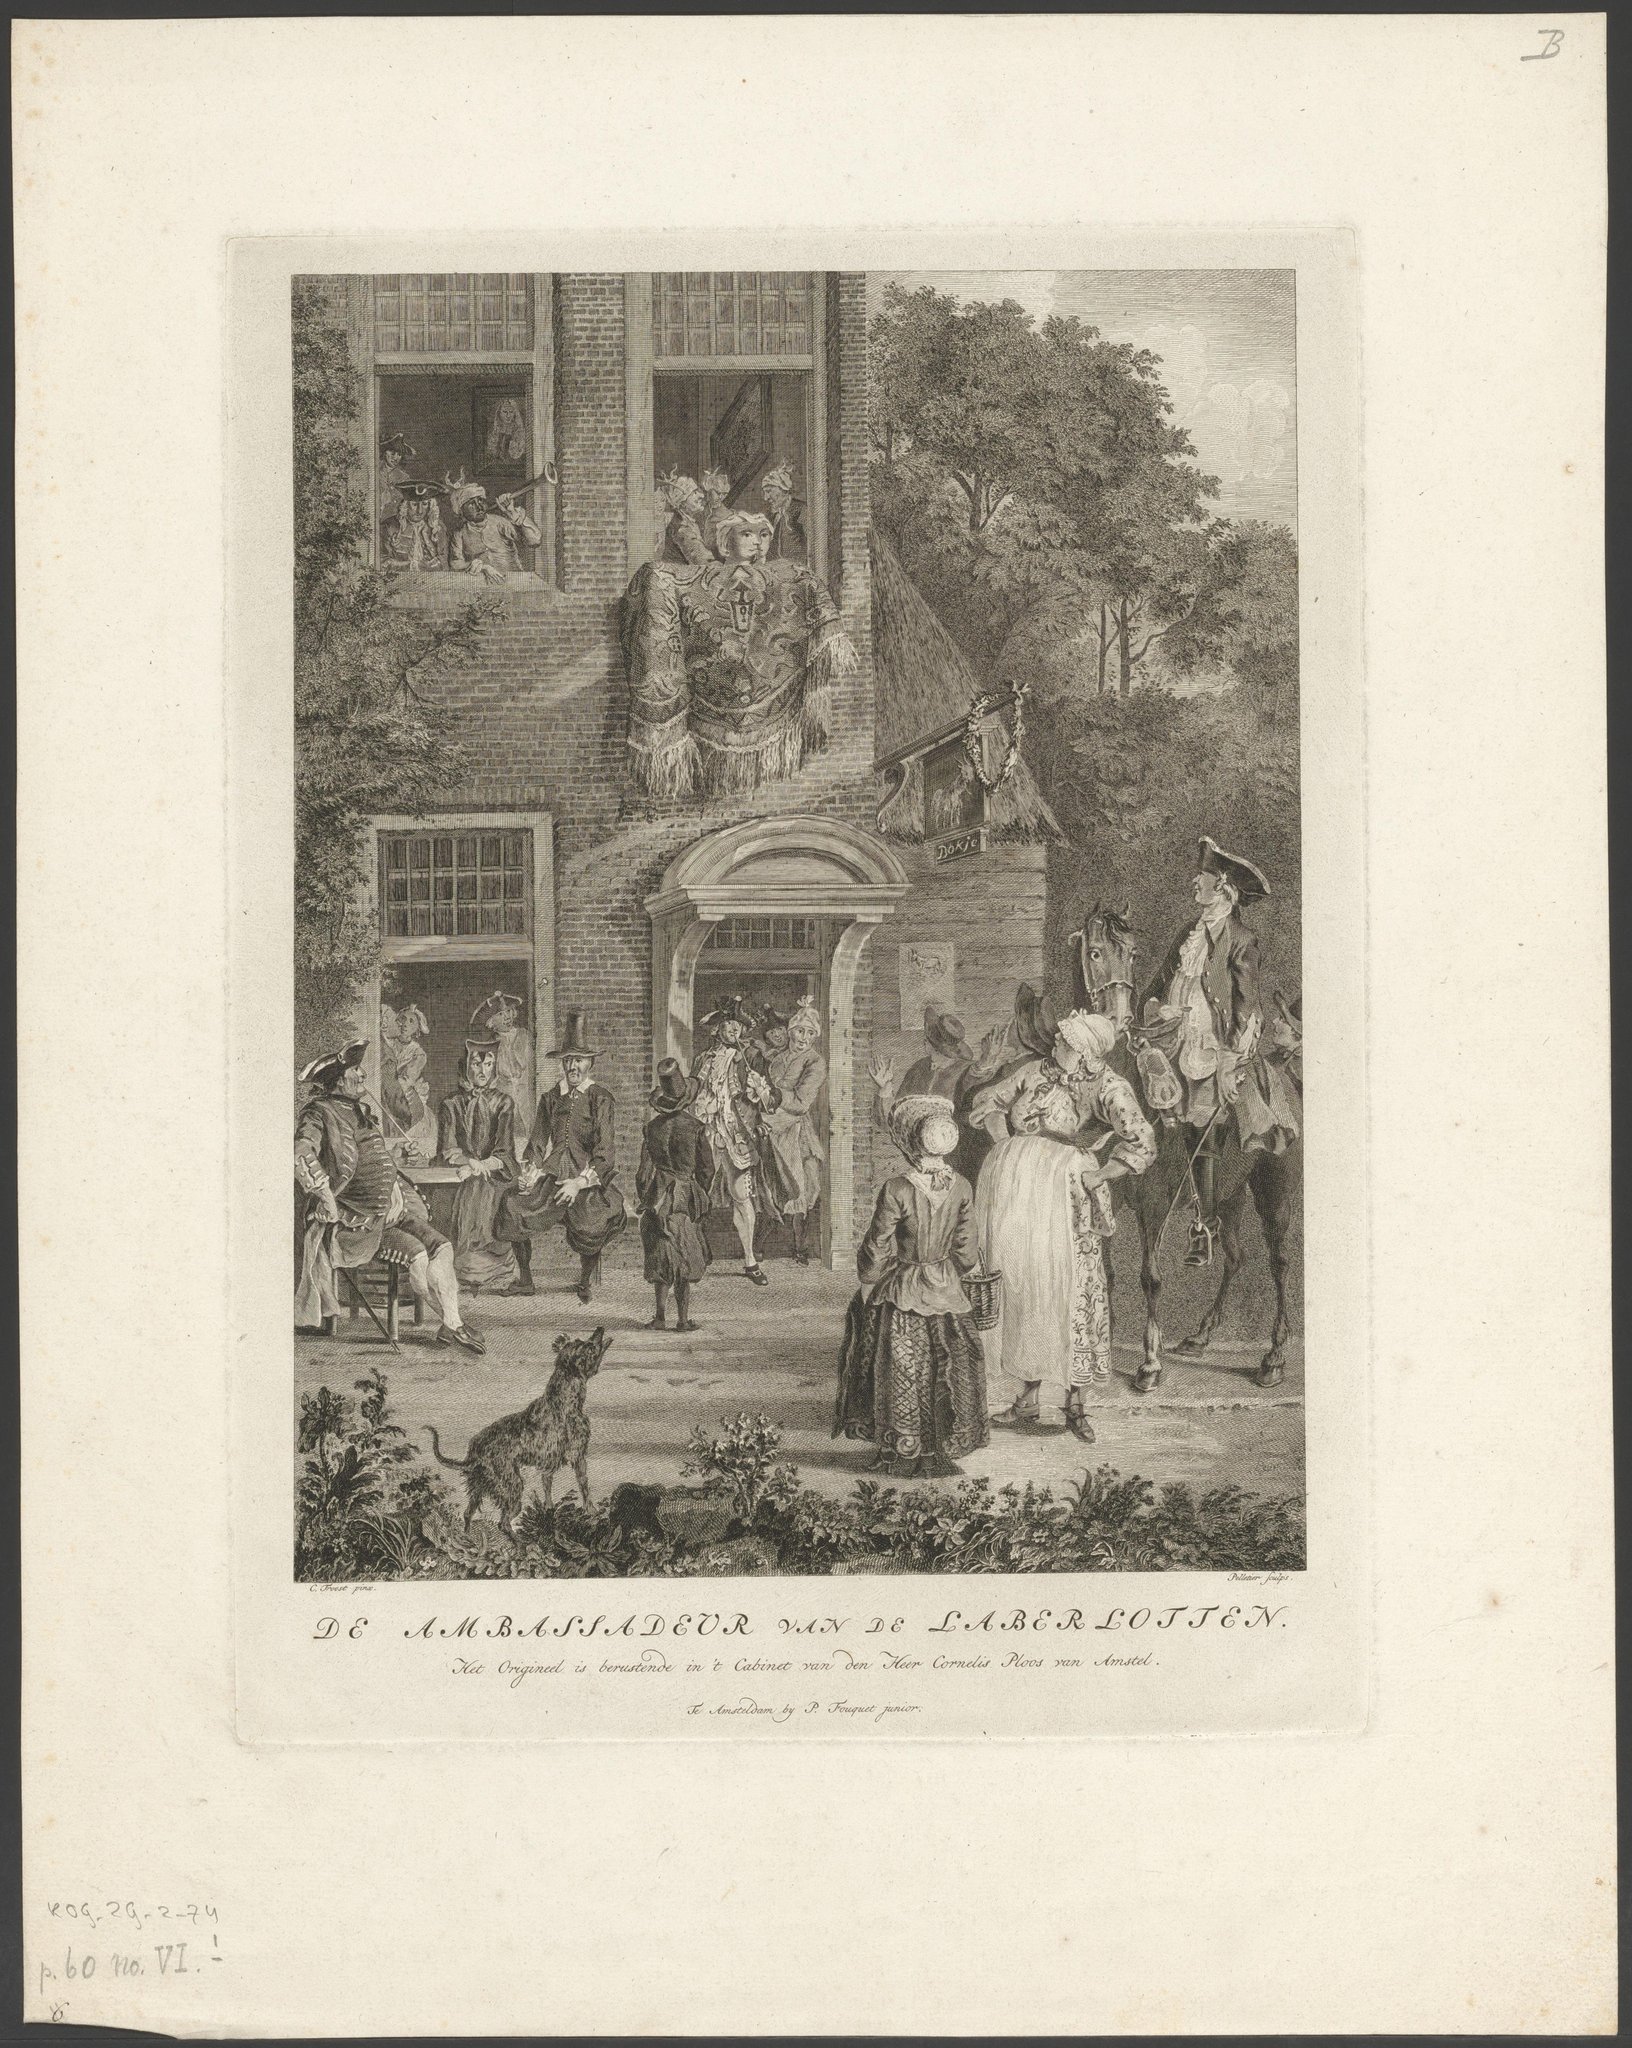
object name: print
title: De Ambassadeur van de Laberlotten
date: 1755-1765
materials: paper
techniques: engraving, etching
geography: amsterdam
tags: painter, print maker, draughtsman, cornelis troost, protestant churches and denominations, pavement, terrace in front of inn or restaurant, buttocks, 'partes posteriores', painting of body or face, hotel, hostelry, inn, comedy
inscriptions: collector's mark: Lugt 2488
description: De ambassadeur der Labberlotten vertoont zich voor het venster van de herberg 't Bokki ('t Bokje) in de Haarlemmerhout. Mogelijk een grap bedreven door Jacob Campo Weyerman en consorten in 1739, mogelijk een grap van de waardin om meer bezoekers te trekken. Een groep mensen kijkt naar het als een gezicht beschilderde achterwerk, uit het venster van de herberg gestoken. In de venster ernaast een trompetter met zwart geverfde gezicht. Links aan een tafel zit de schilder, Cornelis Troost, zelf.